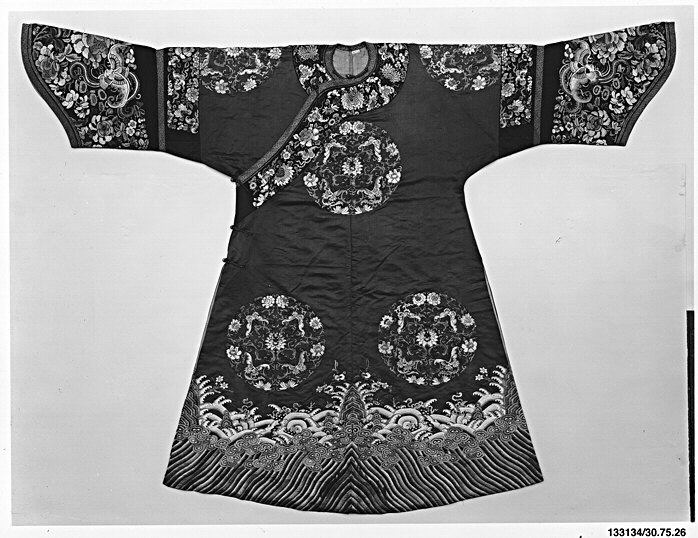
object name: ceremonial robe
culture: chinese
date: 1767-1833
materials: silk